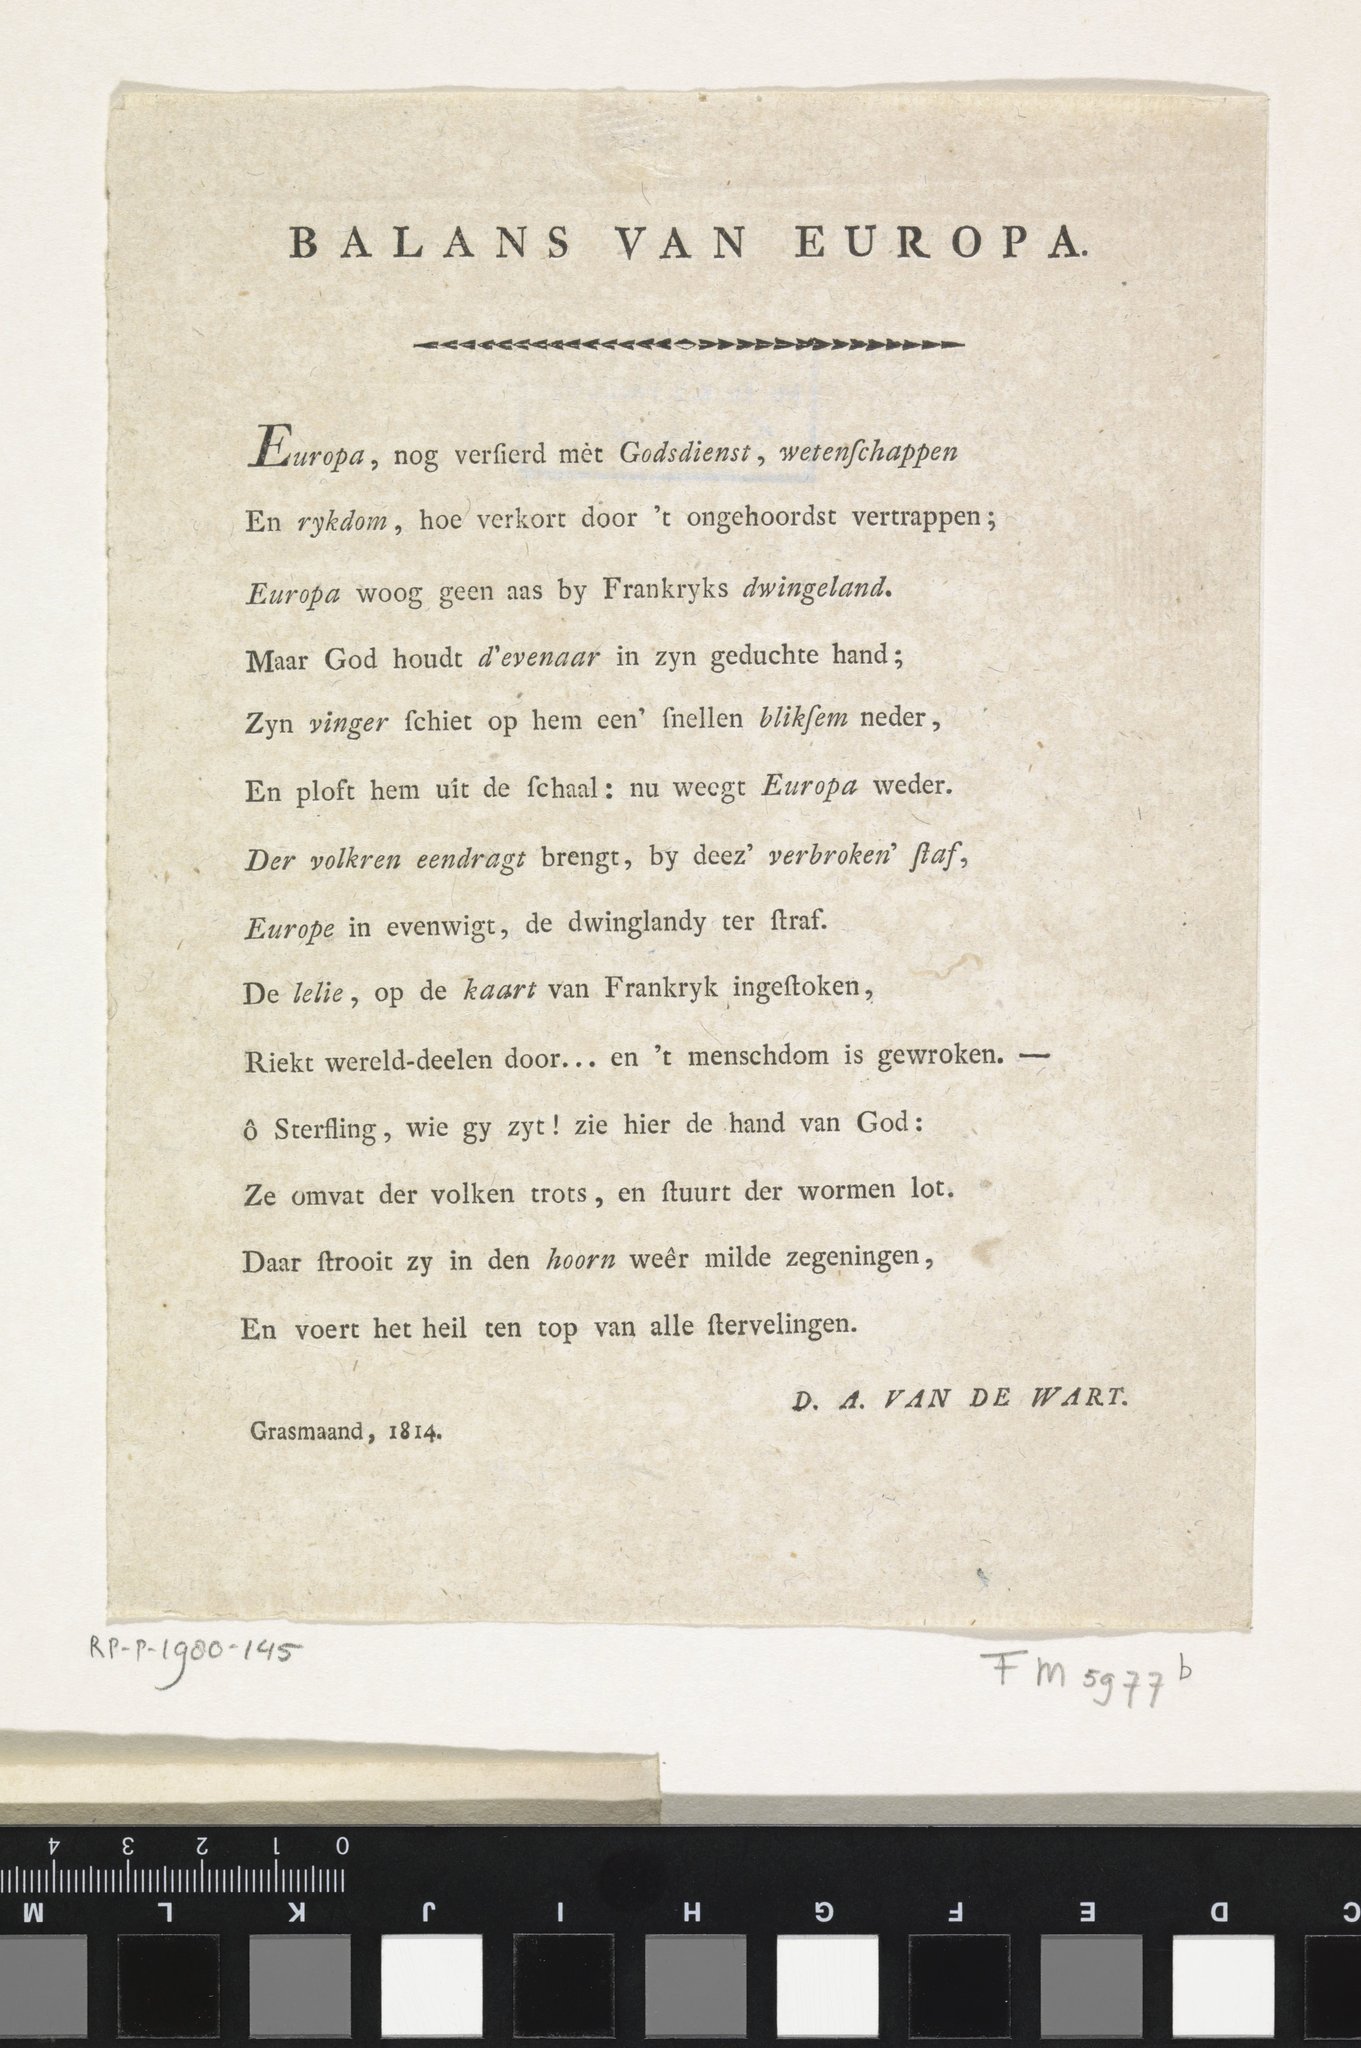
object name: text sheet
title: Balans van Europa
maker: derk anthony van de wart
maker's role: draughtsman, painter, print maker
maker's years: 1767-1824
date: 1804-1814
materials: paper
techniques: letterpress printing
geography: netherlands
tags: napoleon i (emperor of the french)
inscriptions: collector's mark: Lugt 2760, collector's mark: Lugt 2228, collector's mark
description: Tekstblad met een vers van veertien regels, met een verklaring van de voorstelling van de spotprent op de val van Napoleon getiteld de Balans van Europa, april 1814.